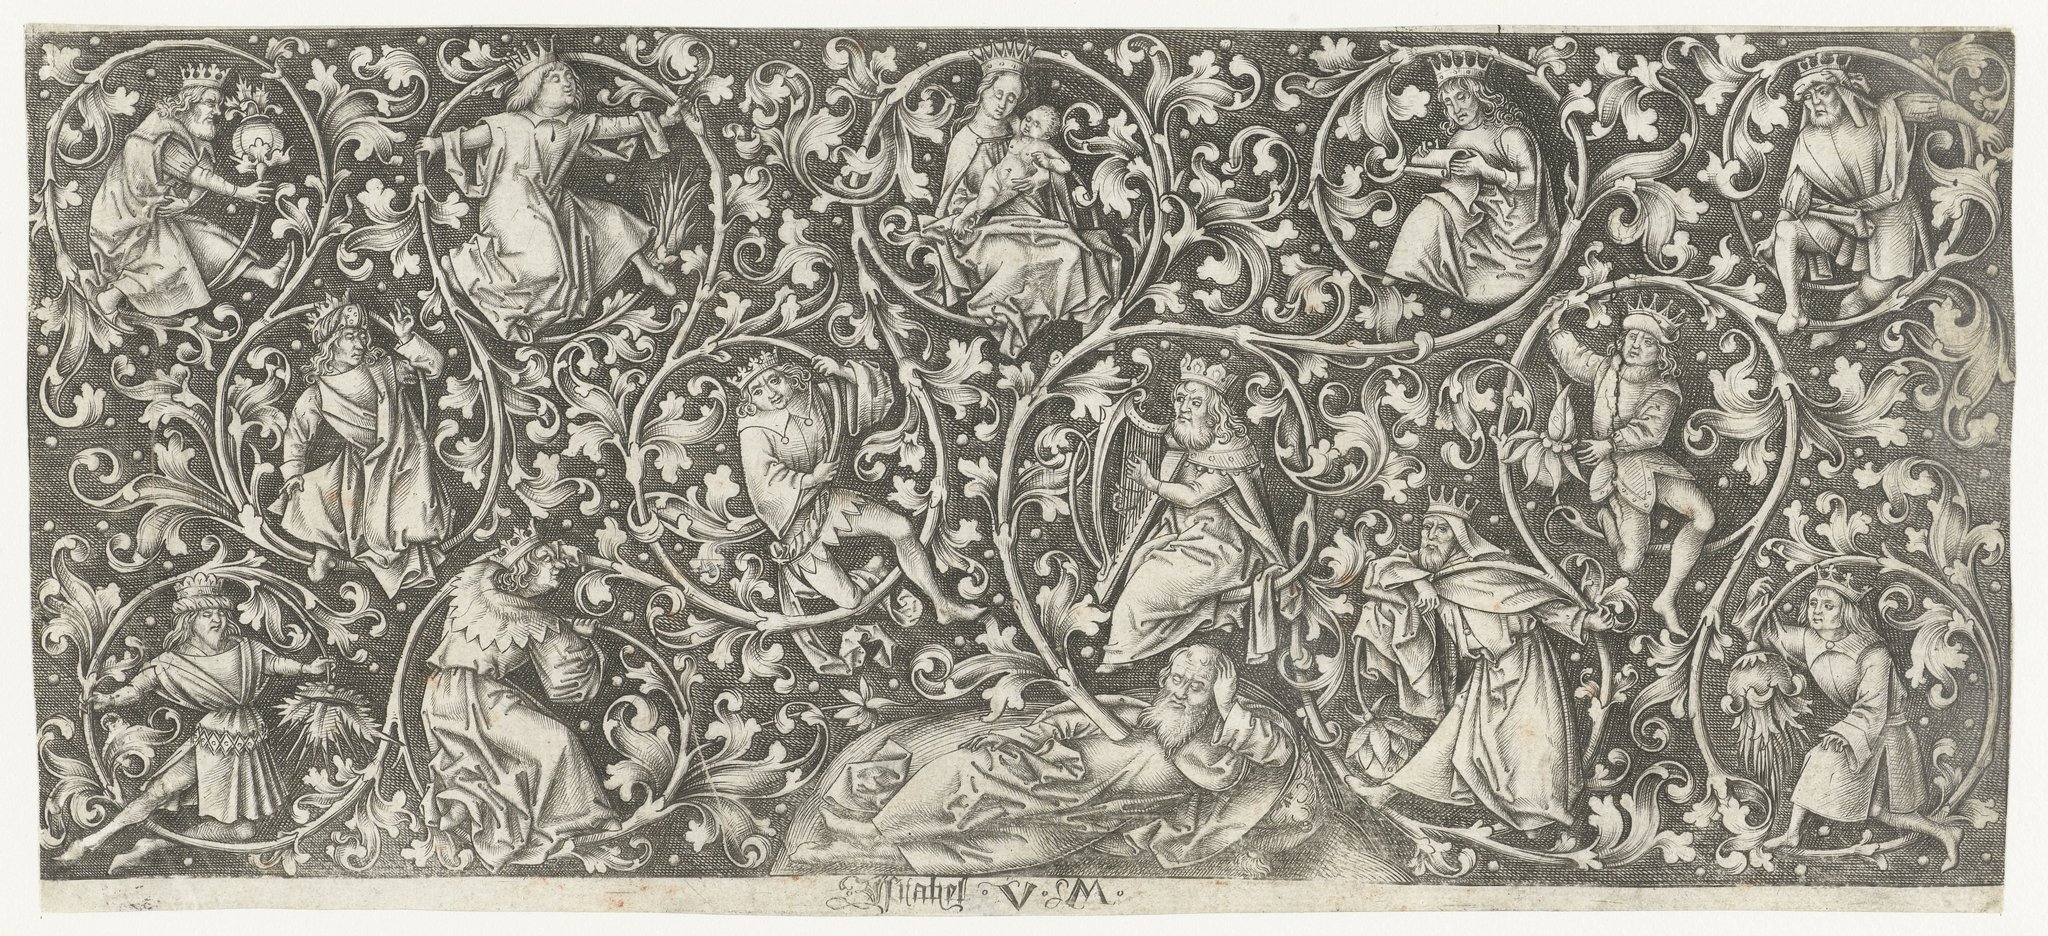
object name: ornament print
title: Tree of Jesse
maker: israhel van meckenem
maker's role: print maker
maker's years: 1440-1517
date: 1455-1503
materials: paper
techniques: engraving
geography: bocholt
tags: tree of jesse: genealogical tree showing christ's ancestors, sprouting from jesse's loins, plants; vegetation (+ ornamental variants of plants)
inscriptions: collector's mark: Lugt 240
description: Uit een slapende man (Jesse) groeit een boom met wijde vertakkingen. Tussen de bladeren verschillende gekroonde figuren, onder wie koning David met zijn harp en Maria met het Christuskind (allen recht boven Jesse).